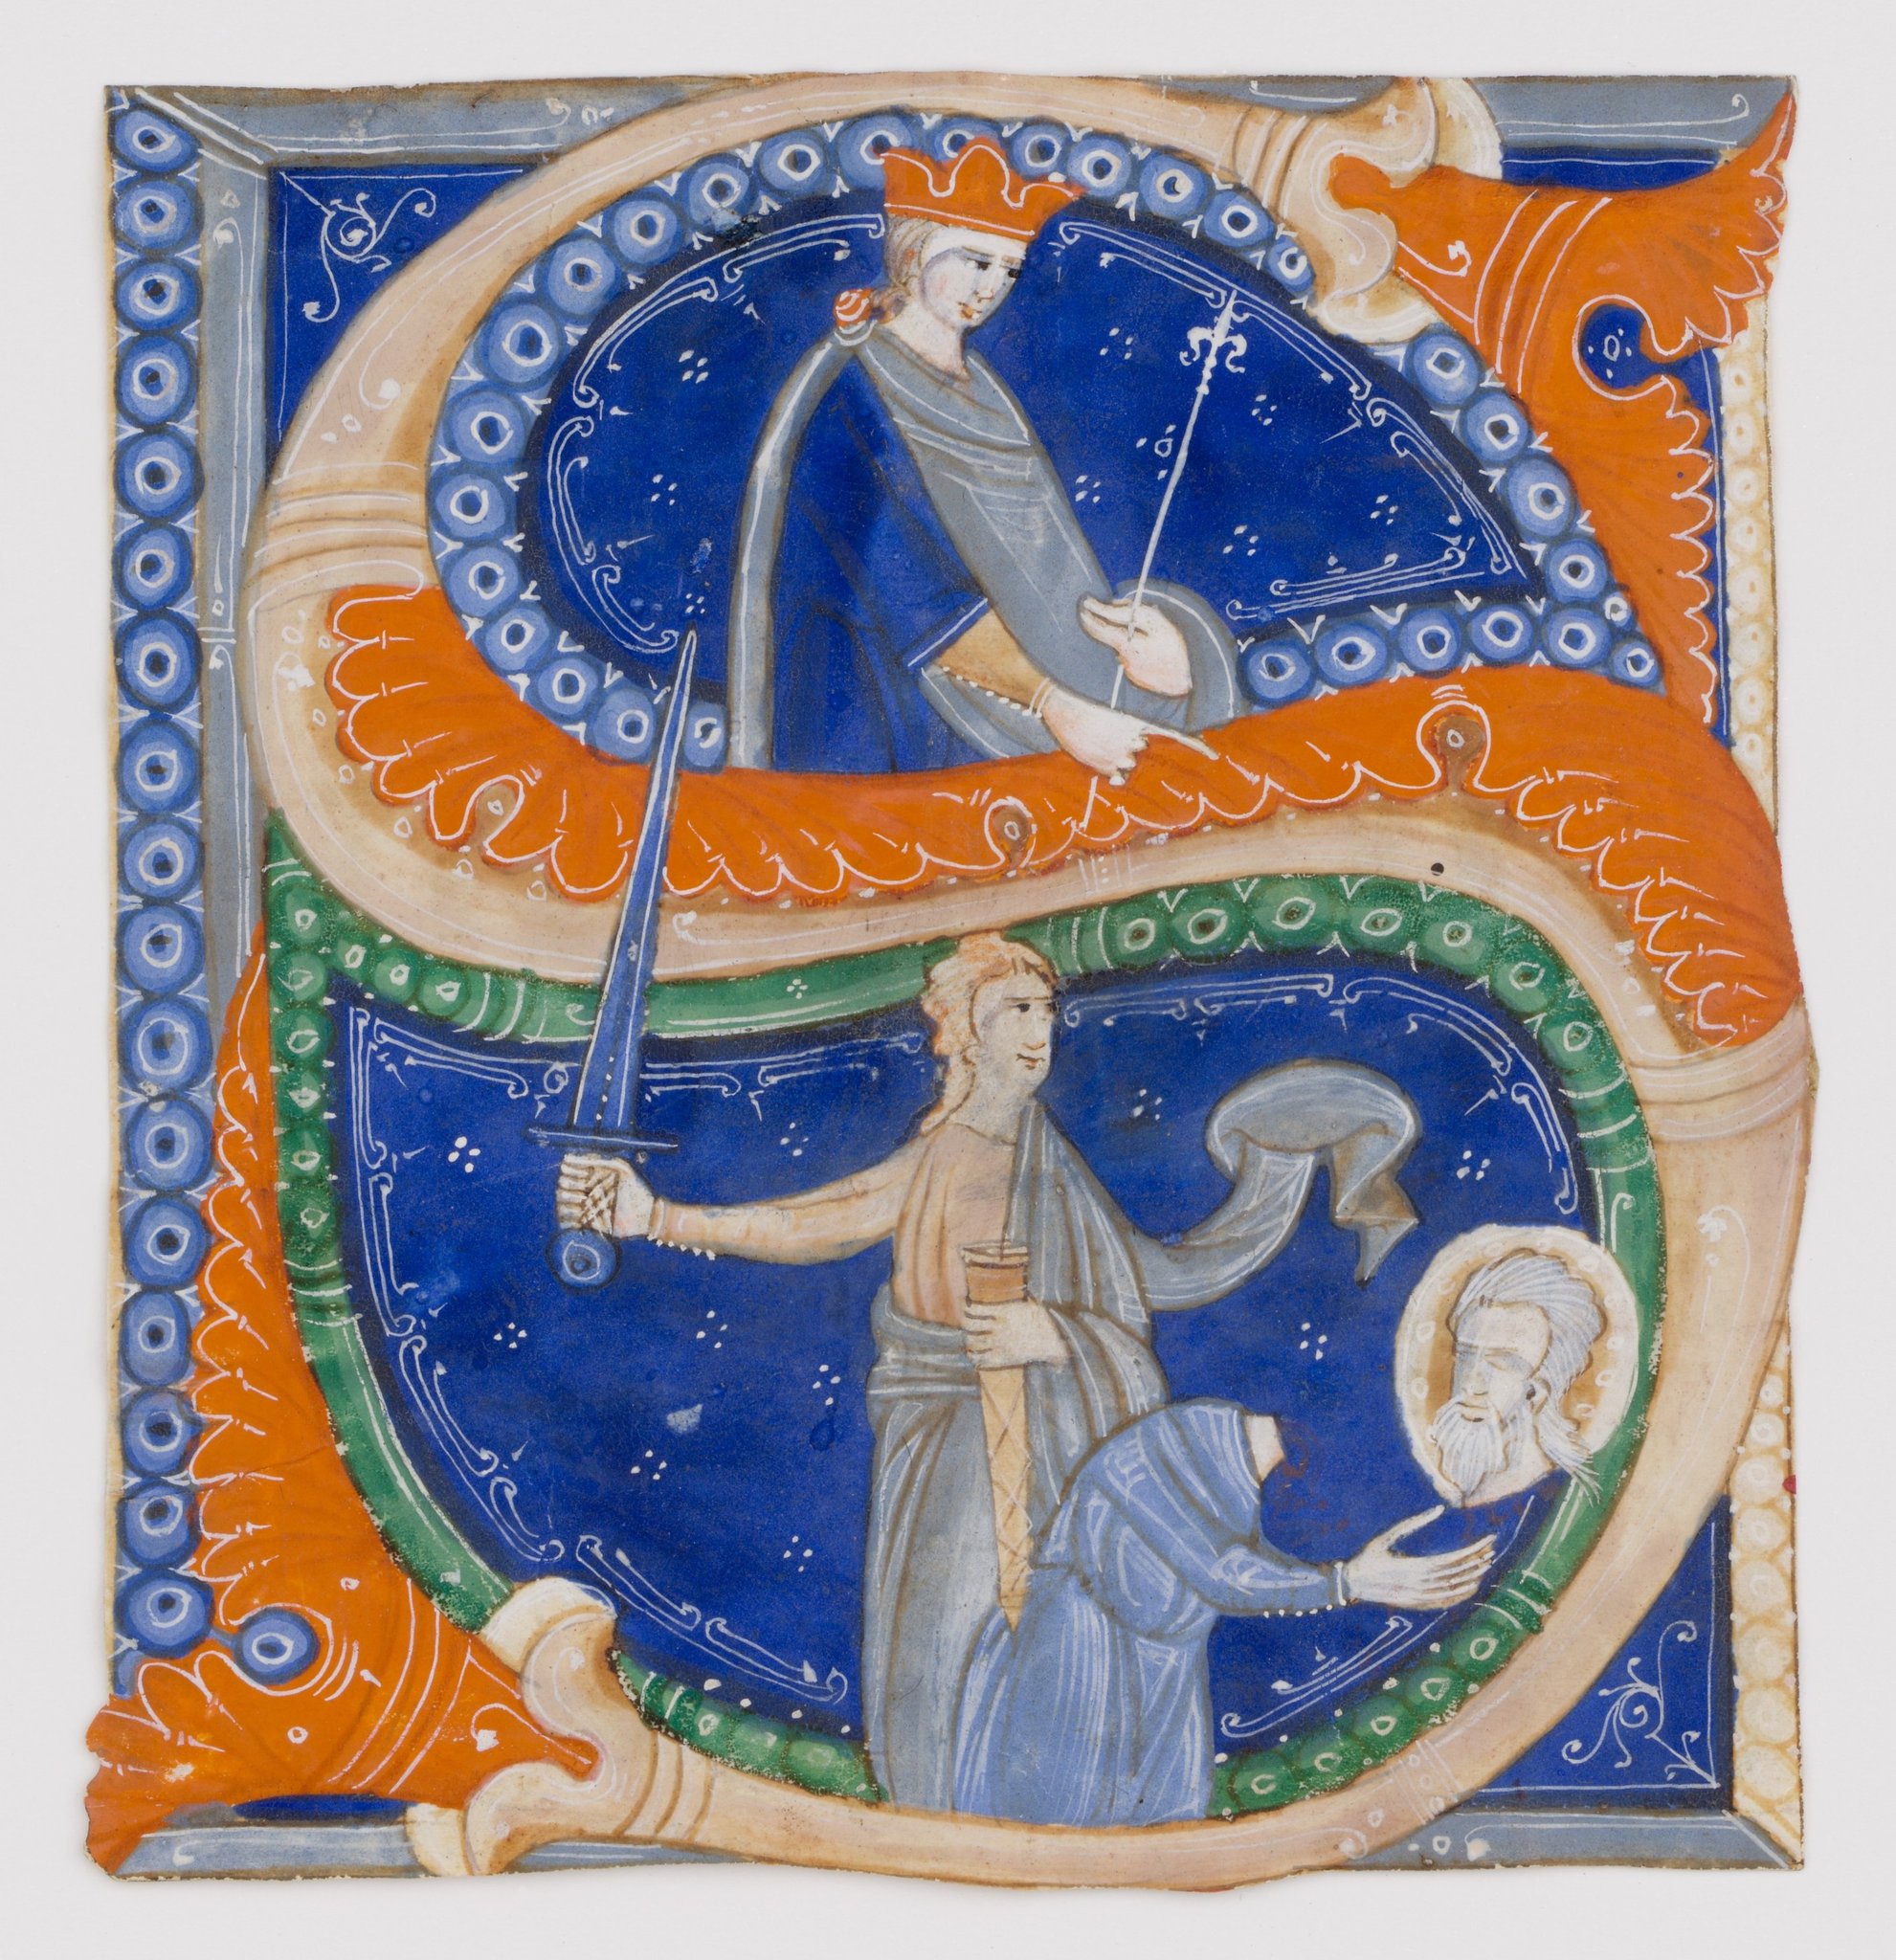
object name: gradual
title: Manuscript Illumination with the Beheading of Saint Paul in an Initial S, from a Gradual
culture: italian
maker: master of bagnacavallo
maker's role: artist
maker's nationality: italian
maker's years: 1275-1299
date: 1278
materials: ink, parchment, paint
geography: italy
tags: swords,saint paul